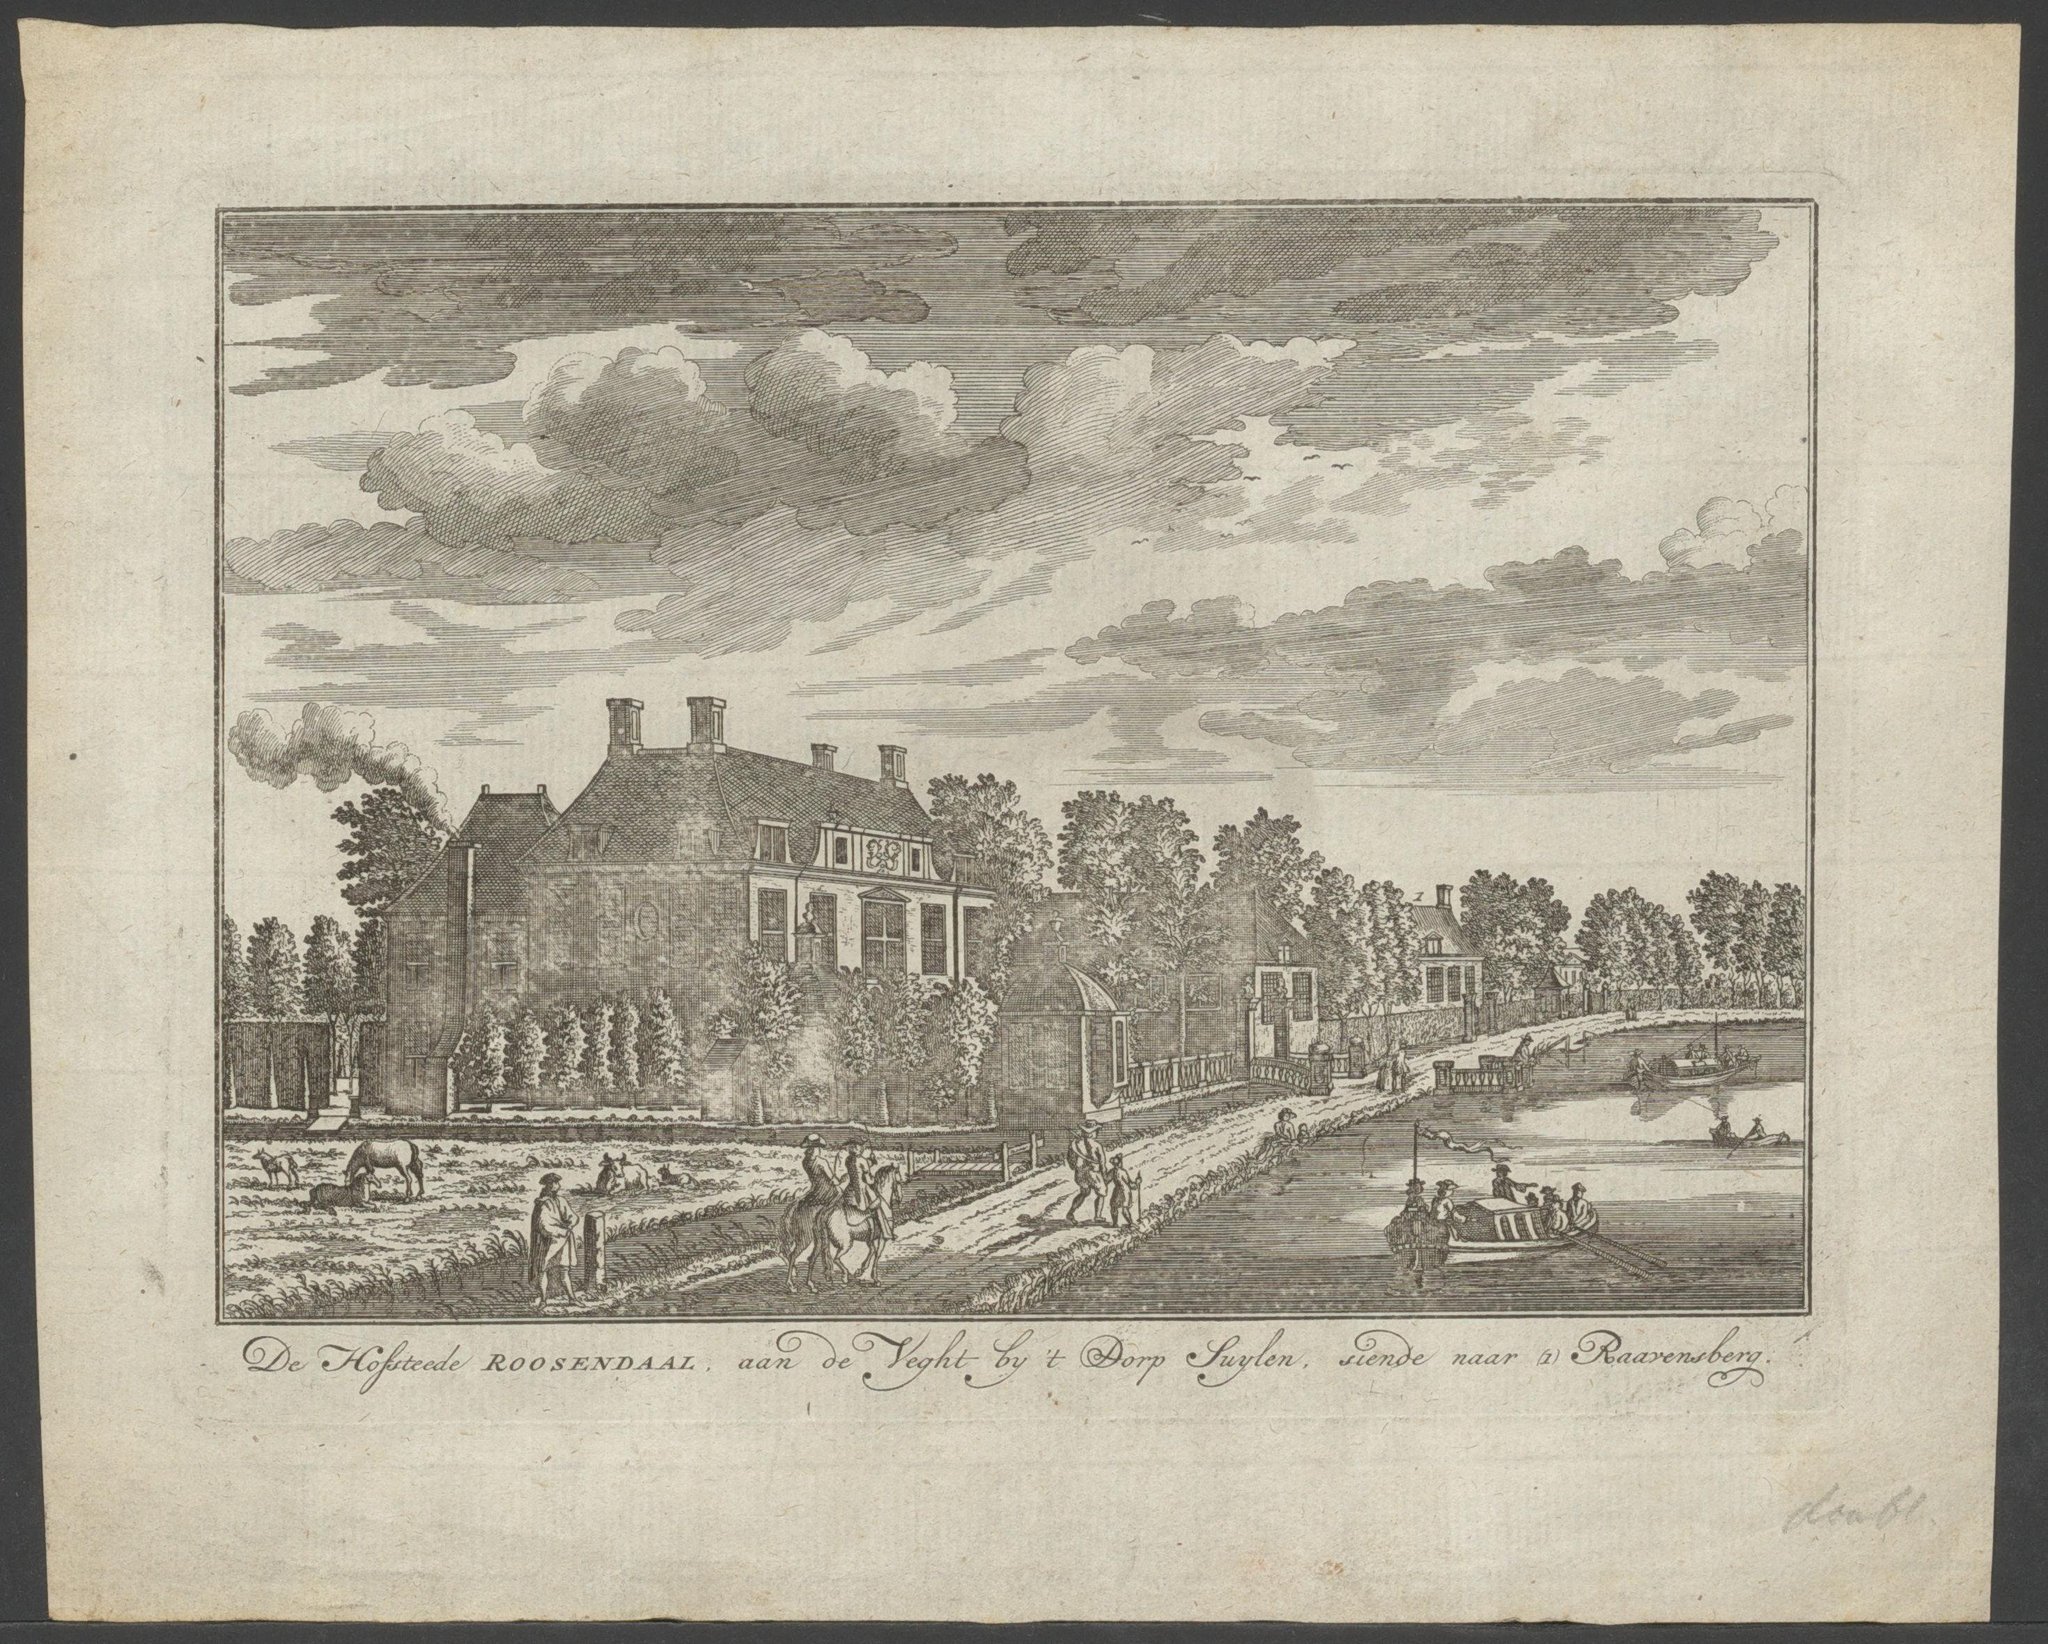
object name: print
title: De Hofsteede Roosendaal, aan de Veght by 't Dorp Suylen, siende naar (1) Raavensberg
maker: Anonymous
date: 1719-1790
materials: paper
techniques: engraving, etching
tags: canal, country-house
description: Prent mogelijk eerder gebruikt in: Leth, Andries de. De zegepraalende Vecht, vertoonende verscheidene gesichten van lustplaatsen, heeren huysen en dorpen, beginnende van Uitrecht en met Muyden besluytende (...). Amsterdam: Weduwe Nicolaus Visscher, 1719. Prent mogelijk eerder gebruikt in: Brouërius van Nidek, Matthaeus. De Vechtstroom, van Utrecht tot Muiden (...). Amsterdam: H. Gartman, W. Vermandel en J.W. Smit, 1790.